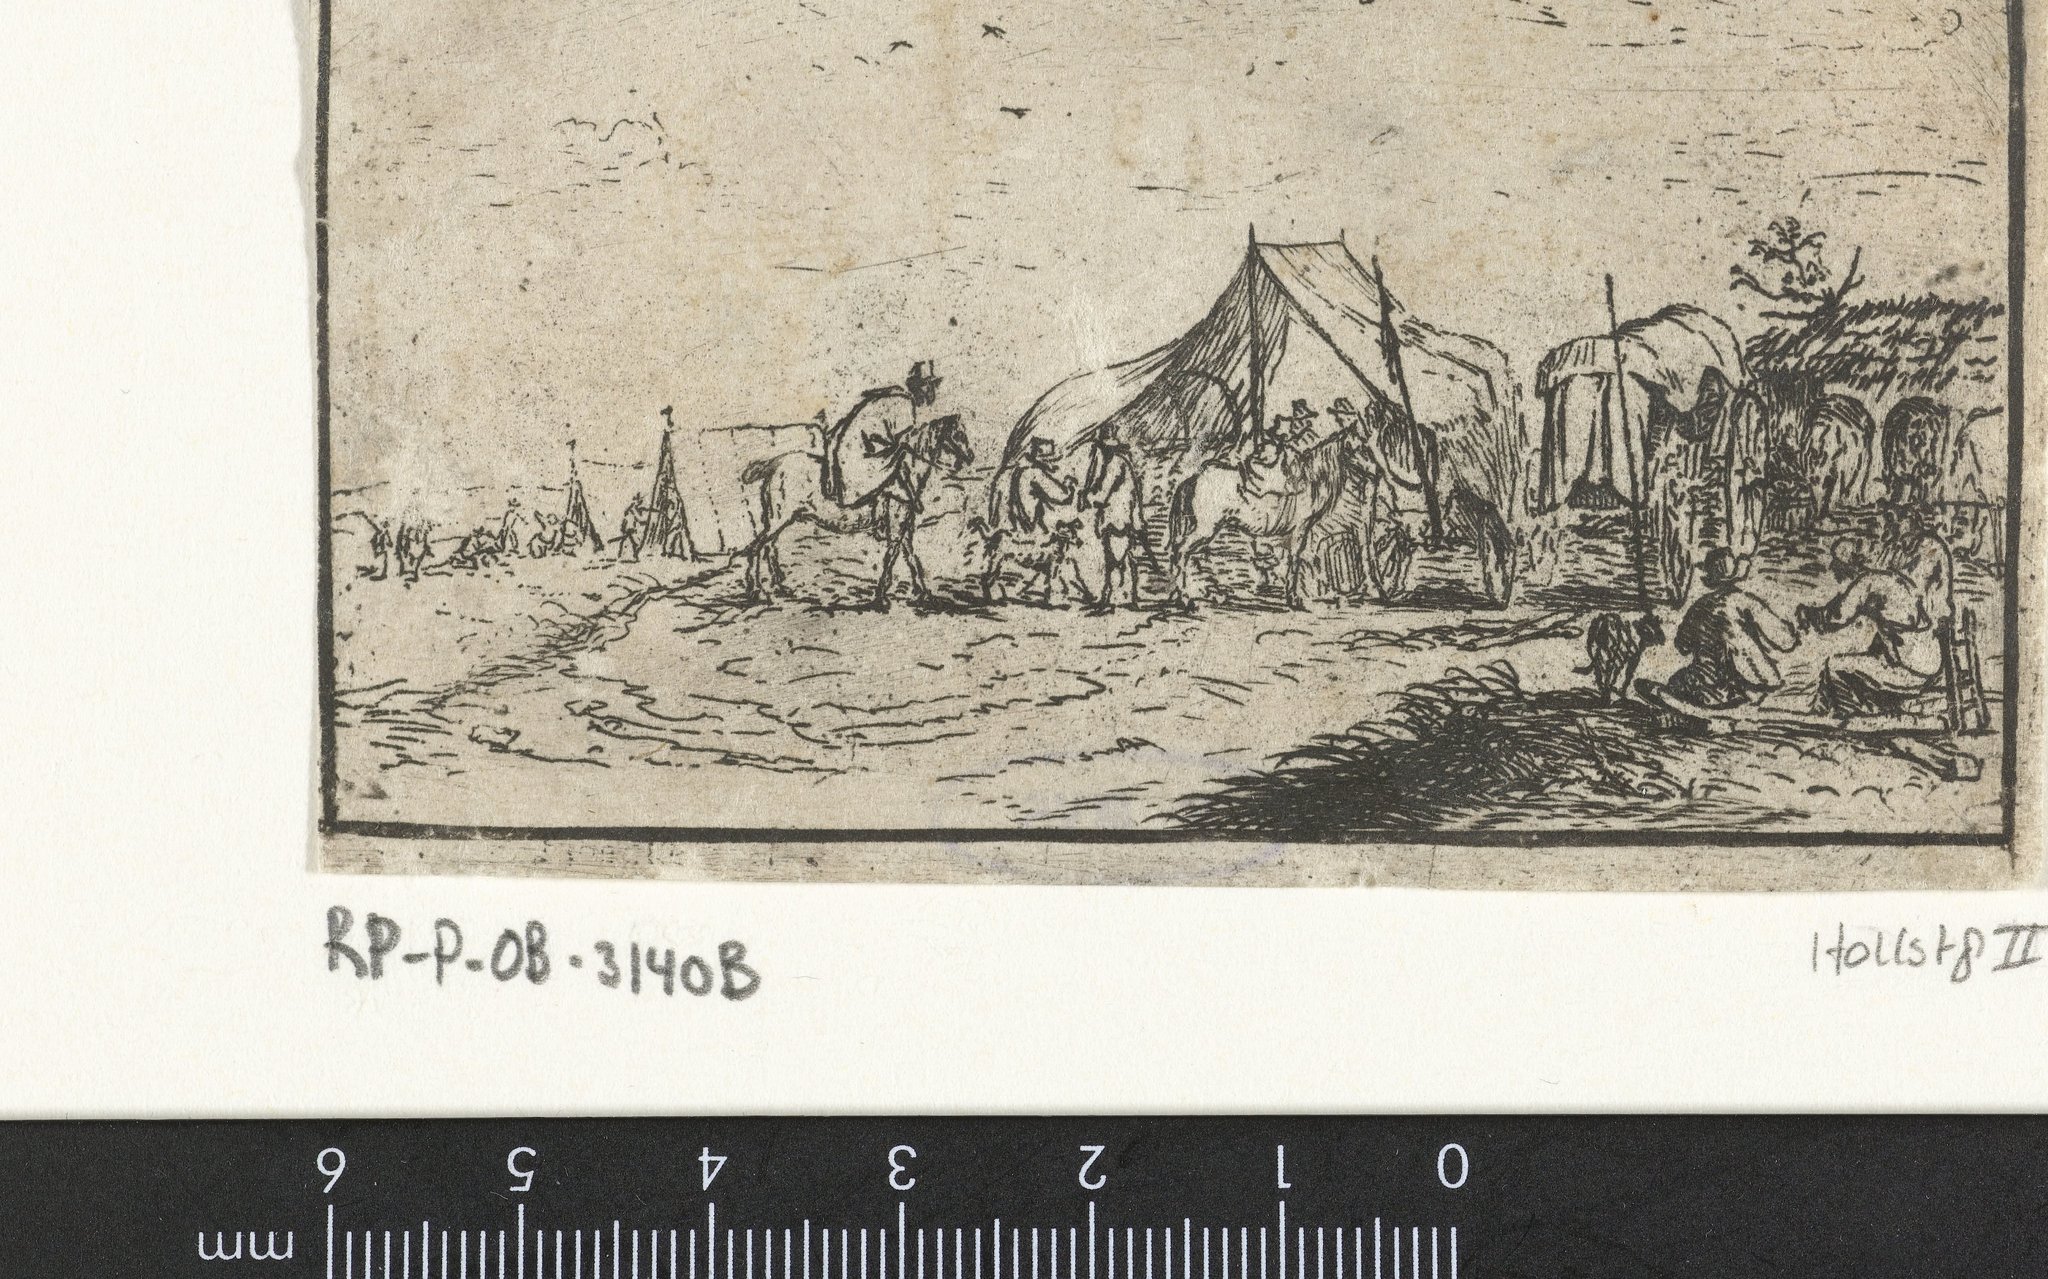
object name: print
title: Kampement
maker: robert van den hoecke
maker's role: draughtsman, painter, print maker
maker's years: 1622-1668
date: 1632-1668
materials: paper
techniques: etching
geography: southern netherlands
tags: tent-camp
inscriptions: collector's mark: Lugt 2228